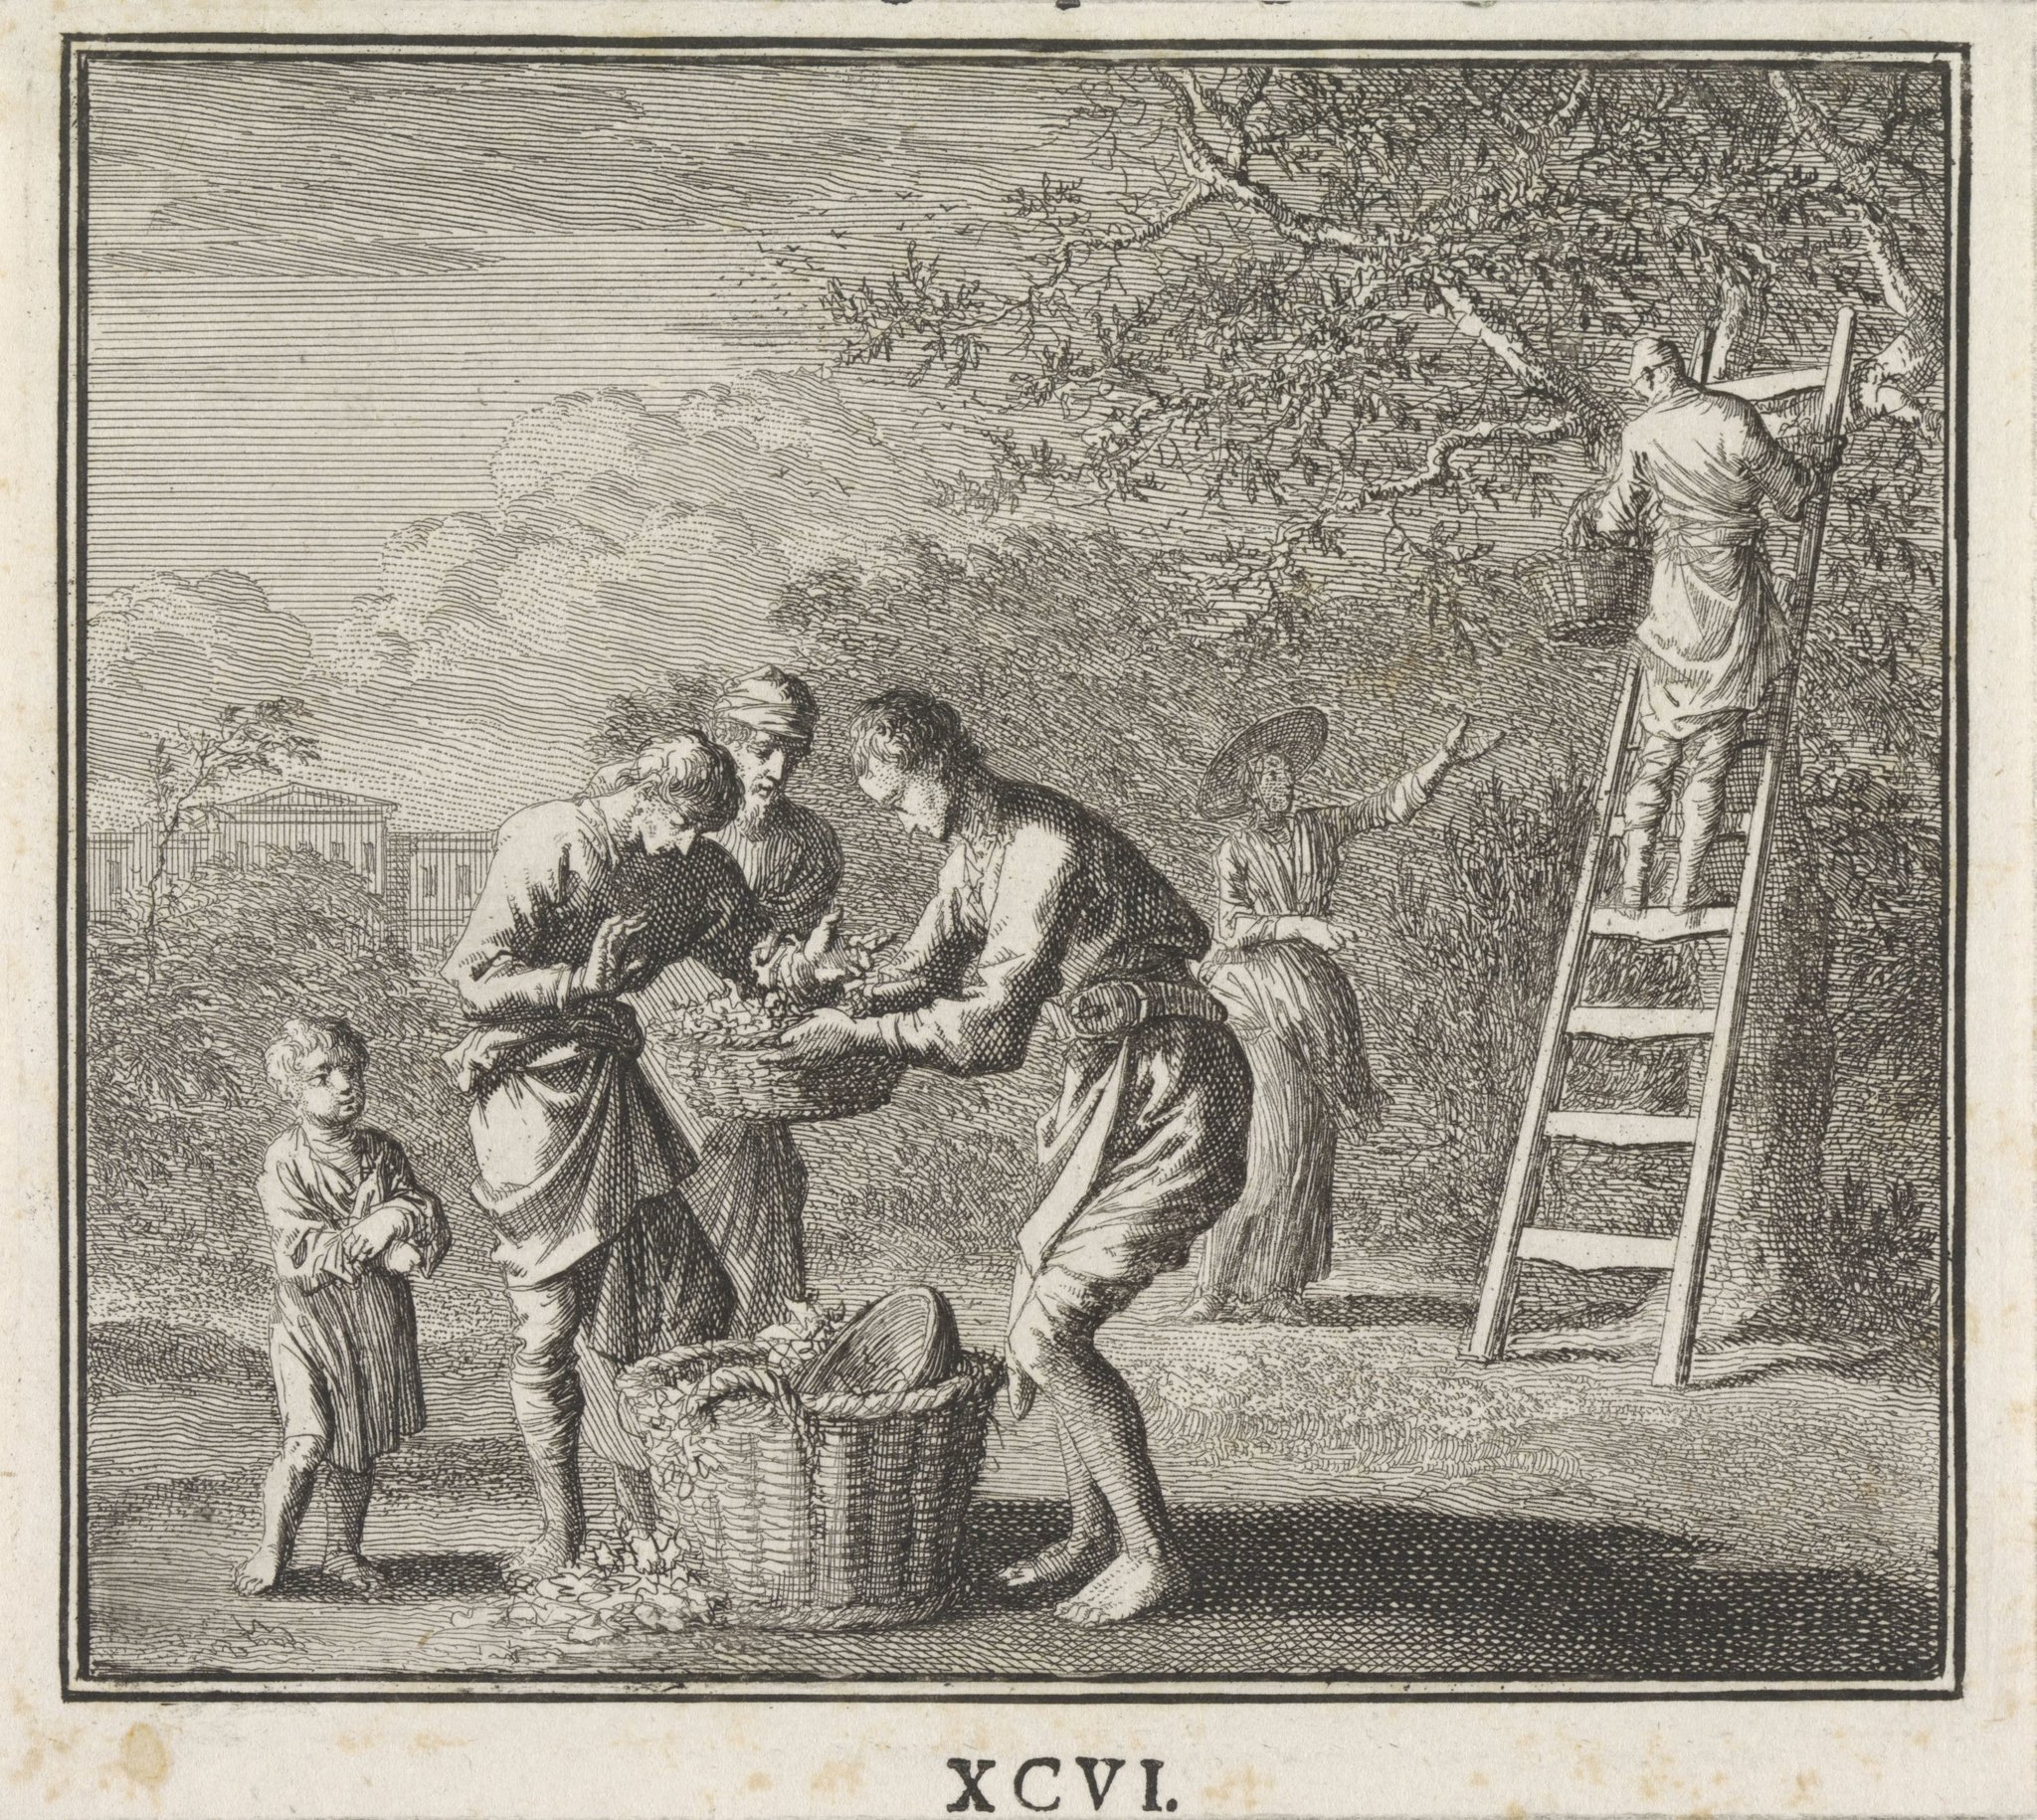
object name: book illustration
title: Mislukte vruchtenoogst vanwege ongedierte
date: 1695-1705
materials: paper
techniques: etching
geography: nuremberg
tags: fruits (+ dying plant), fruits (+ withering, leaves or flowers falling off), insects (+ animals eating and drinking), picking fruit, fruit harvest, abstract ideas and concepts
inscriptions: collector's mark: Lugt 2228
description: Boekillustratie voor Weigel, Christoph. Ethica Naturalis seu Documenta Moralia e Variis rerum Naturalium proprietatibus Virtutum Vitiorumq symbolicis imaginibus collecta. Neurenberg: Christoph Weigel: c. 1700.